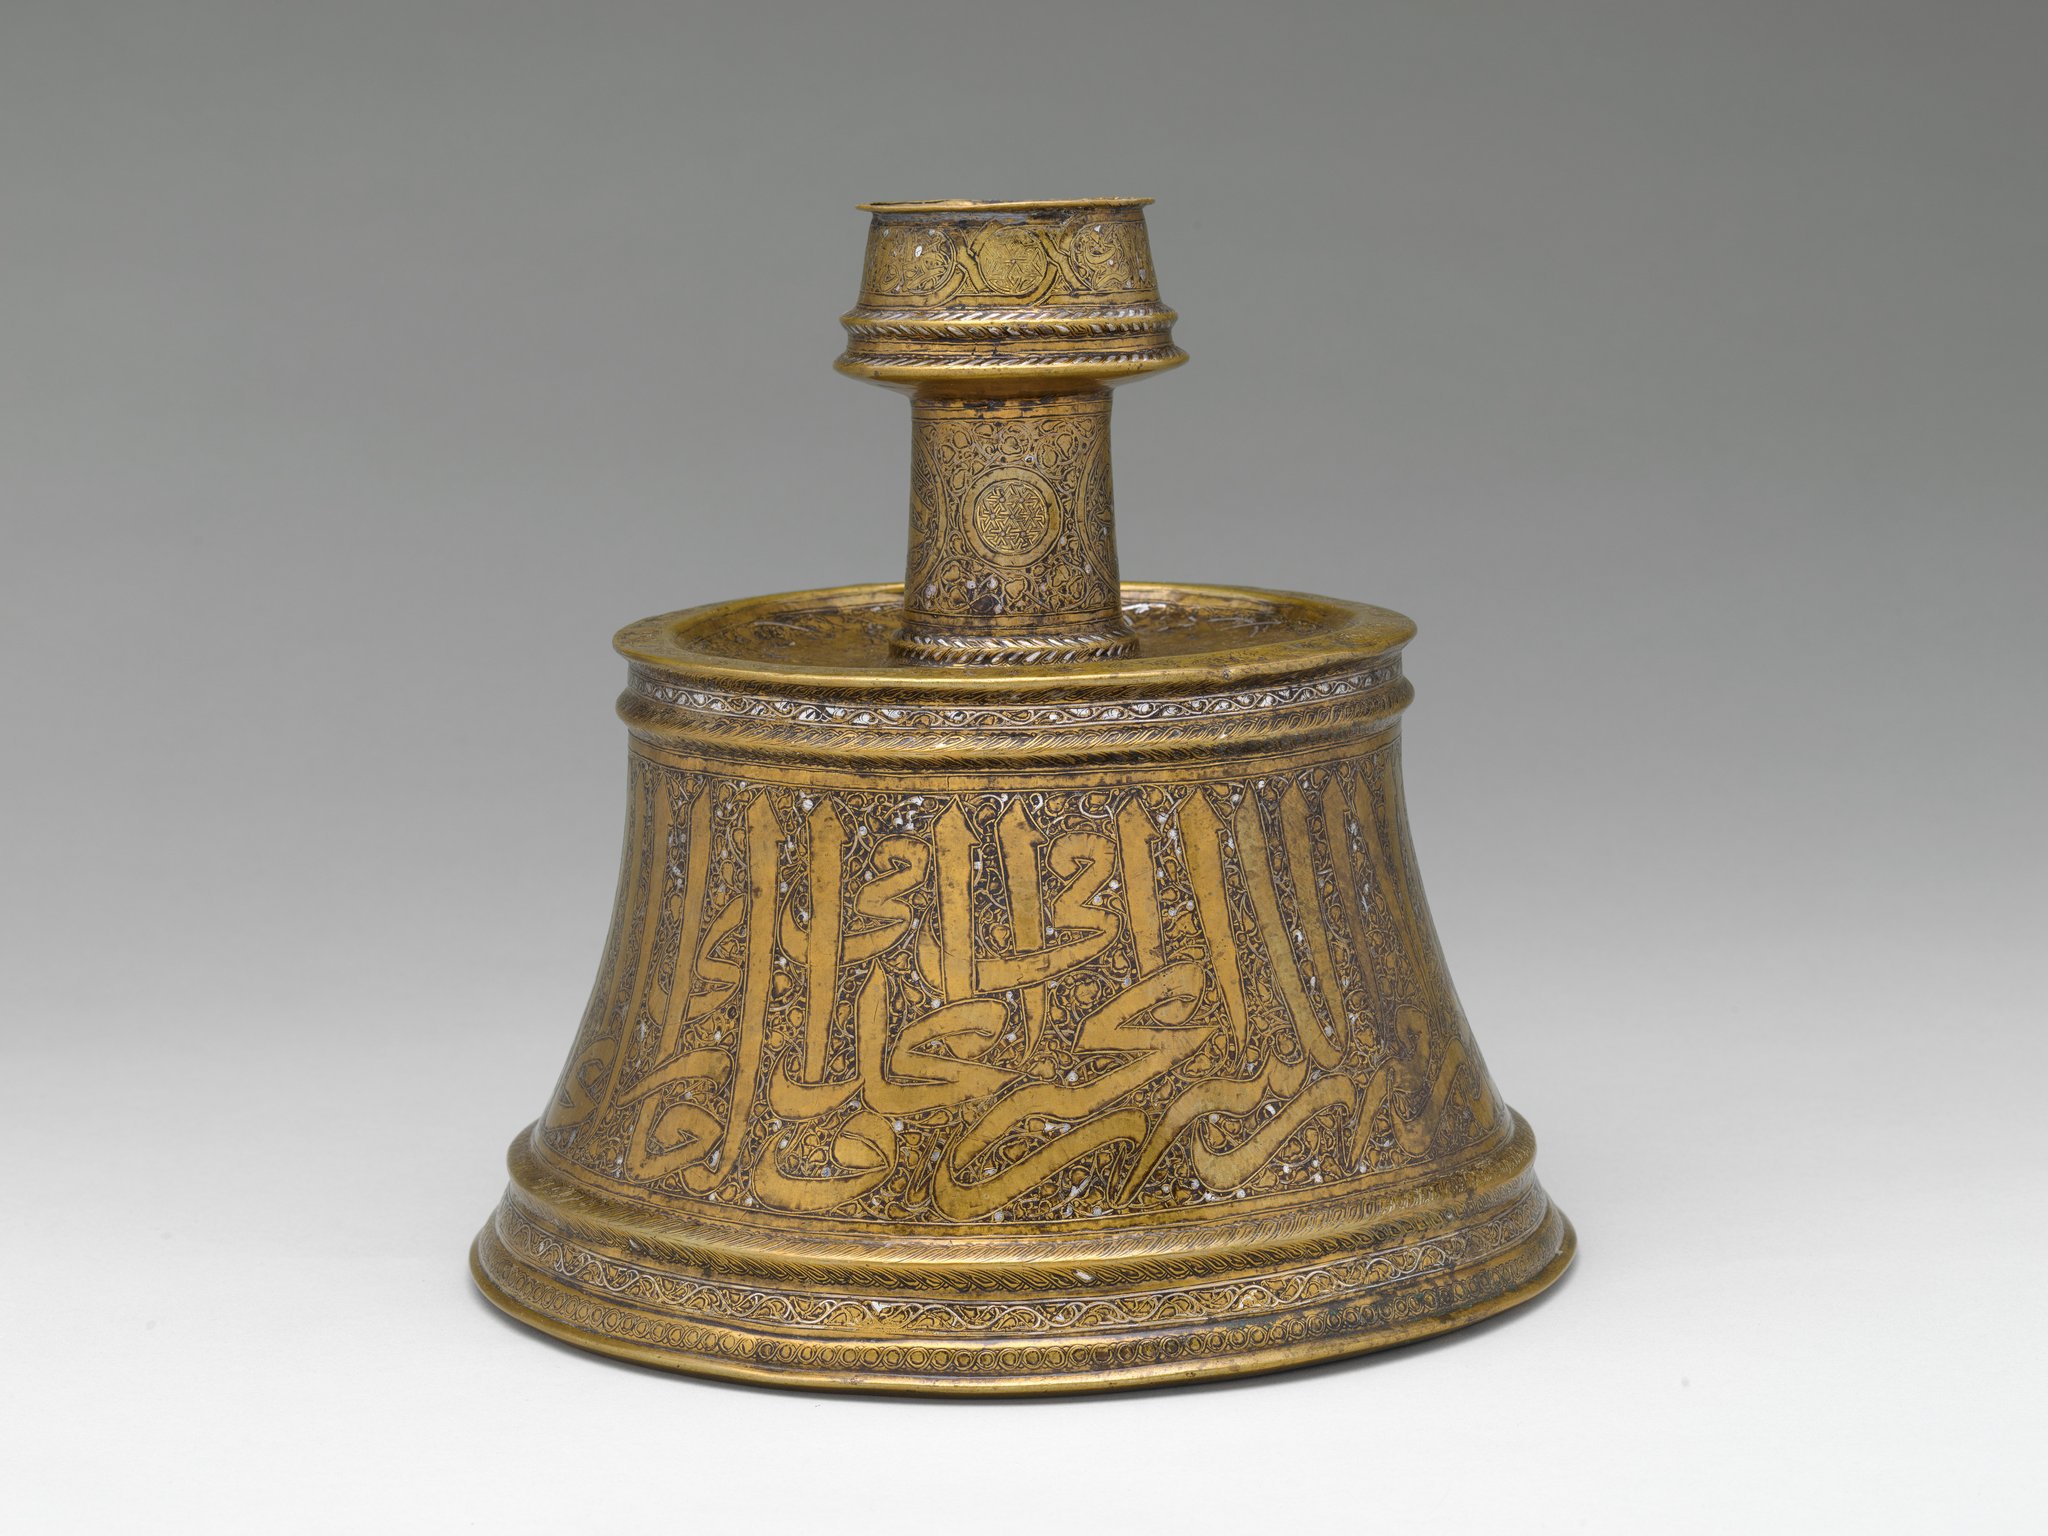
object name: candlestick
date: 1301-1350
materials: brass, silver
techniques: inlay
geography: egypt or syria